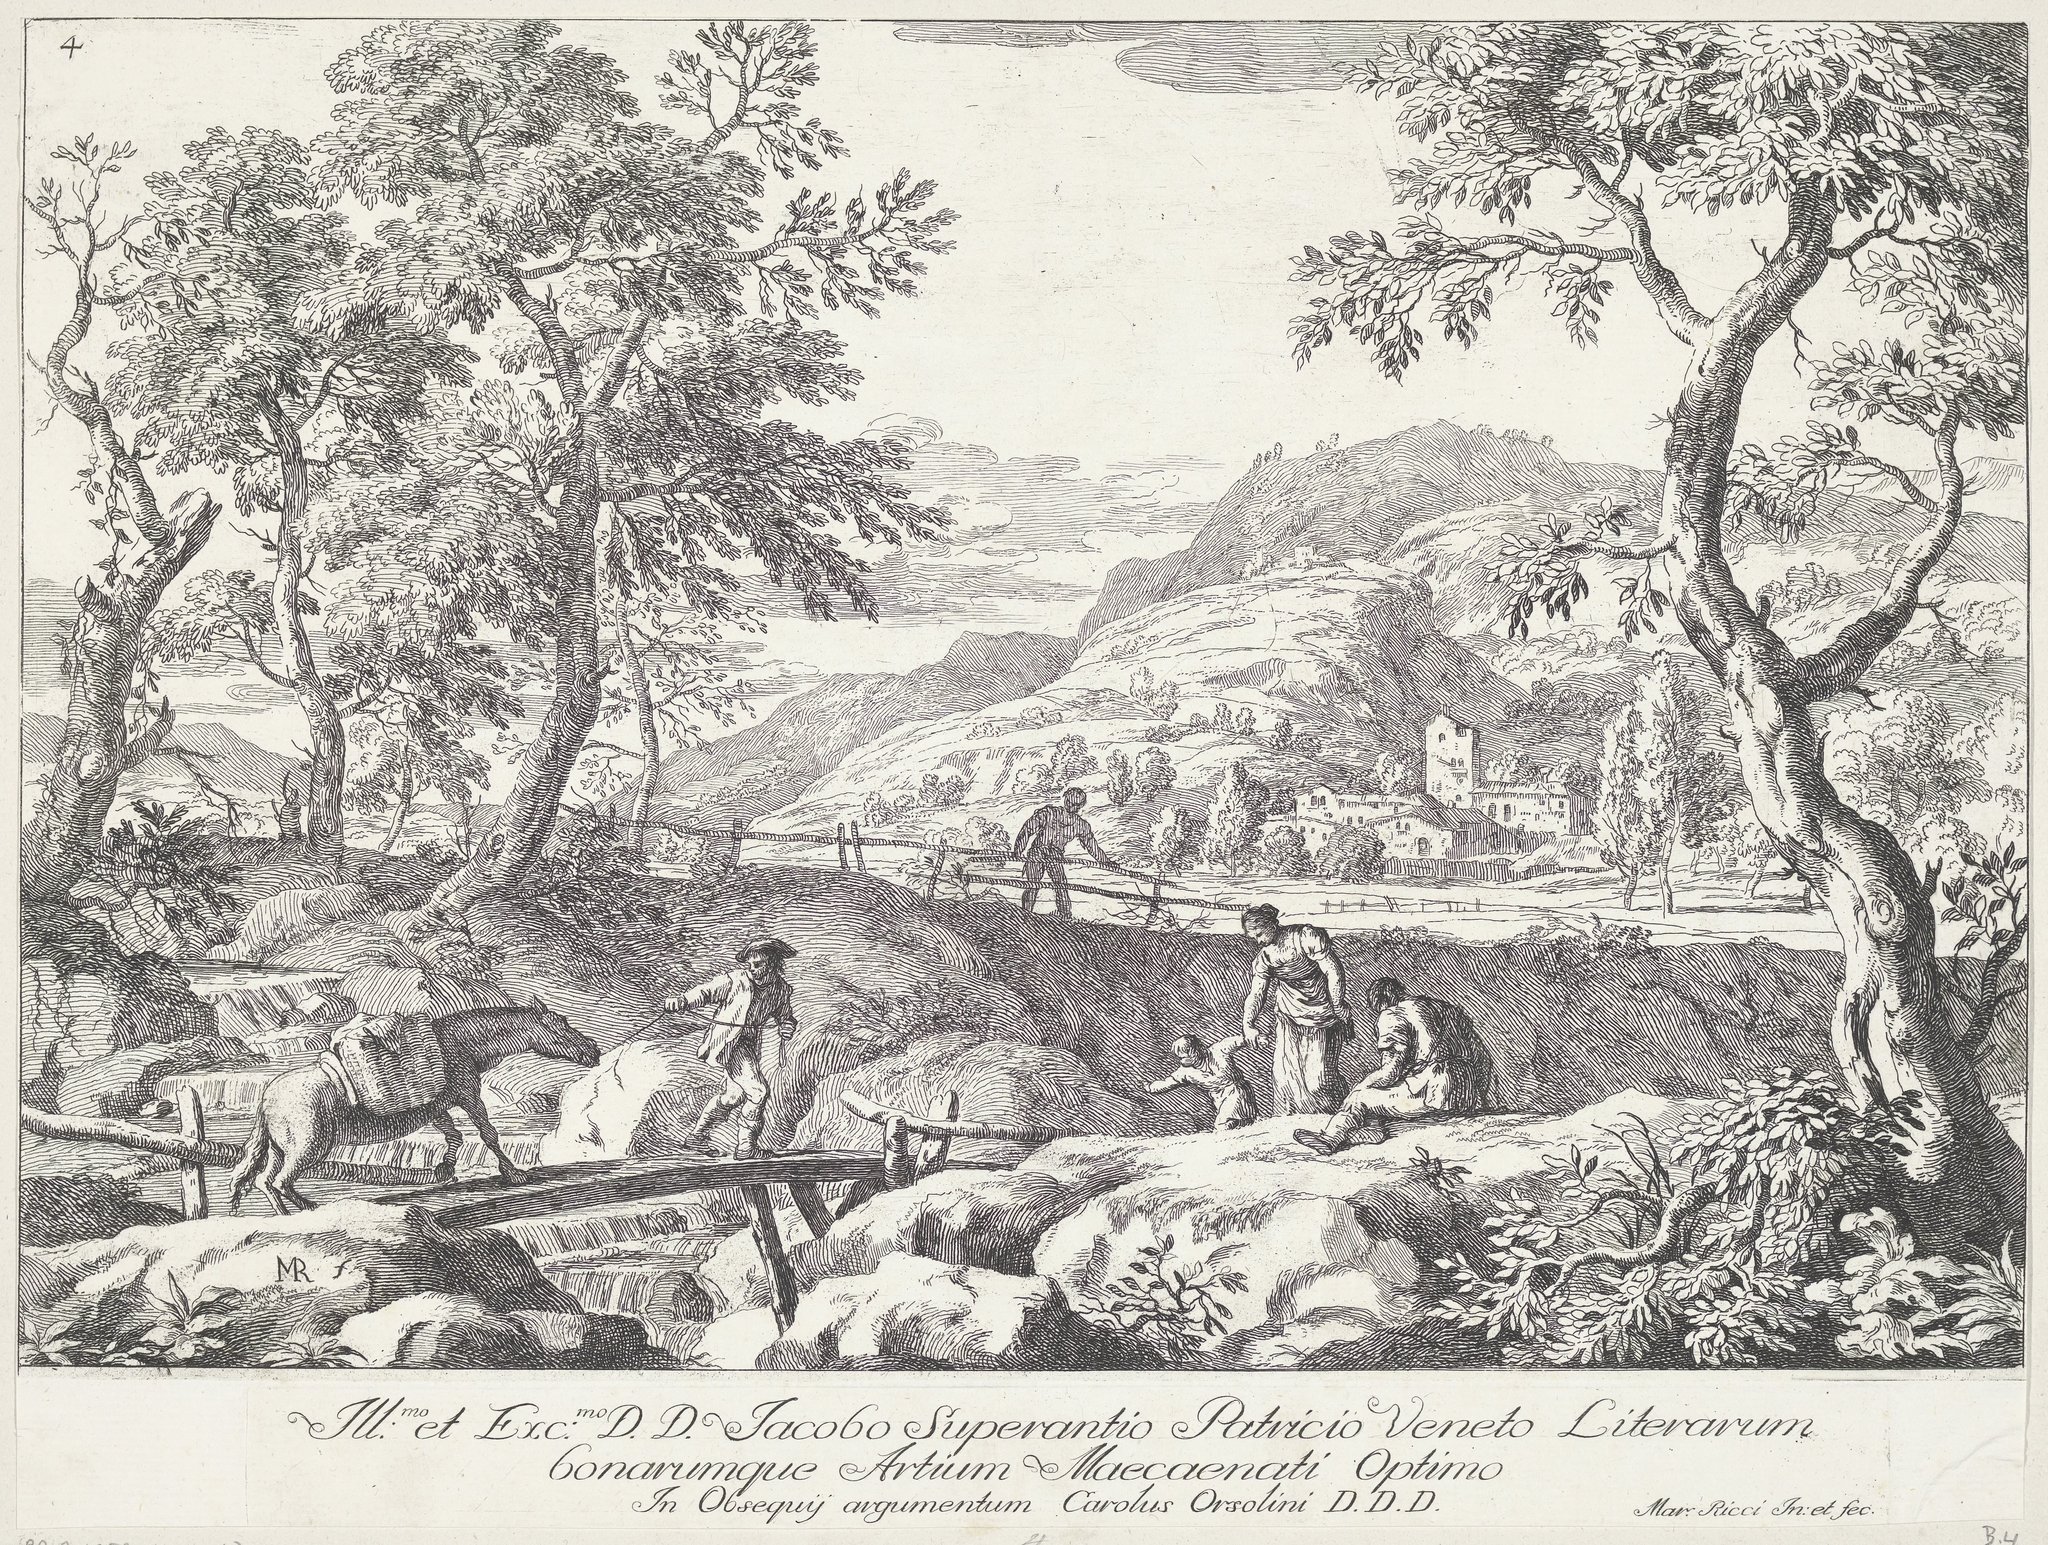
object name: print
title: Landschap met boer en paard op brug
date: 1730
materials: paper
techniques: etching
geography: italy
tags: landscapes, horse, bridge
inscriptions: collector's mark: Lugt 2228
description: Deze prent maakt deel uit van een reeks van twintig prenten door Marco Ricci. De prenten zijn na de dood van Ricci in 1730 gebundeld door Carlo Orsolini en voorzien van een titelprent. Een getekende voorstudie wordt bewaard in Windsor Castle te Windsor (inv. nr. 01147).